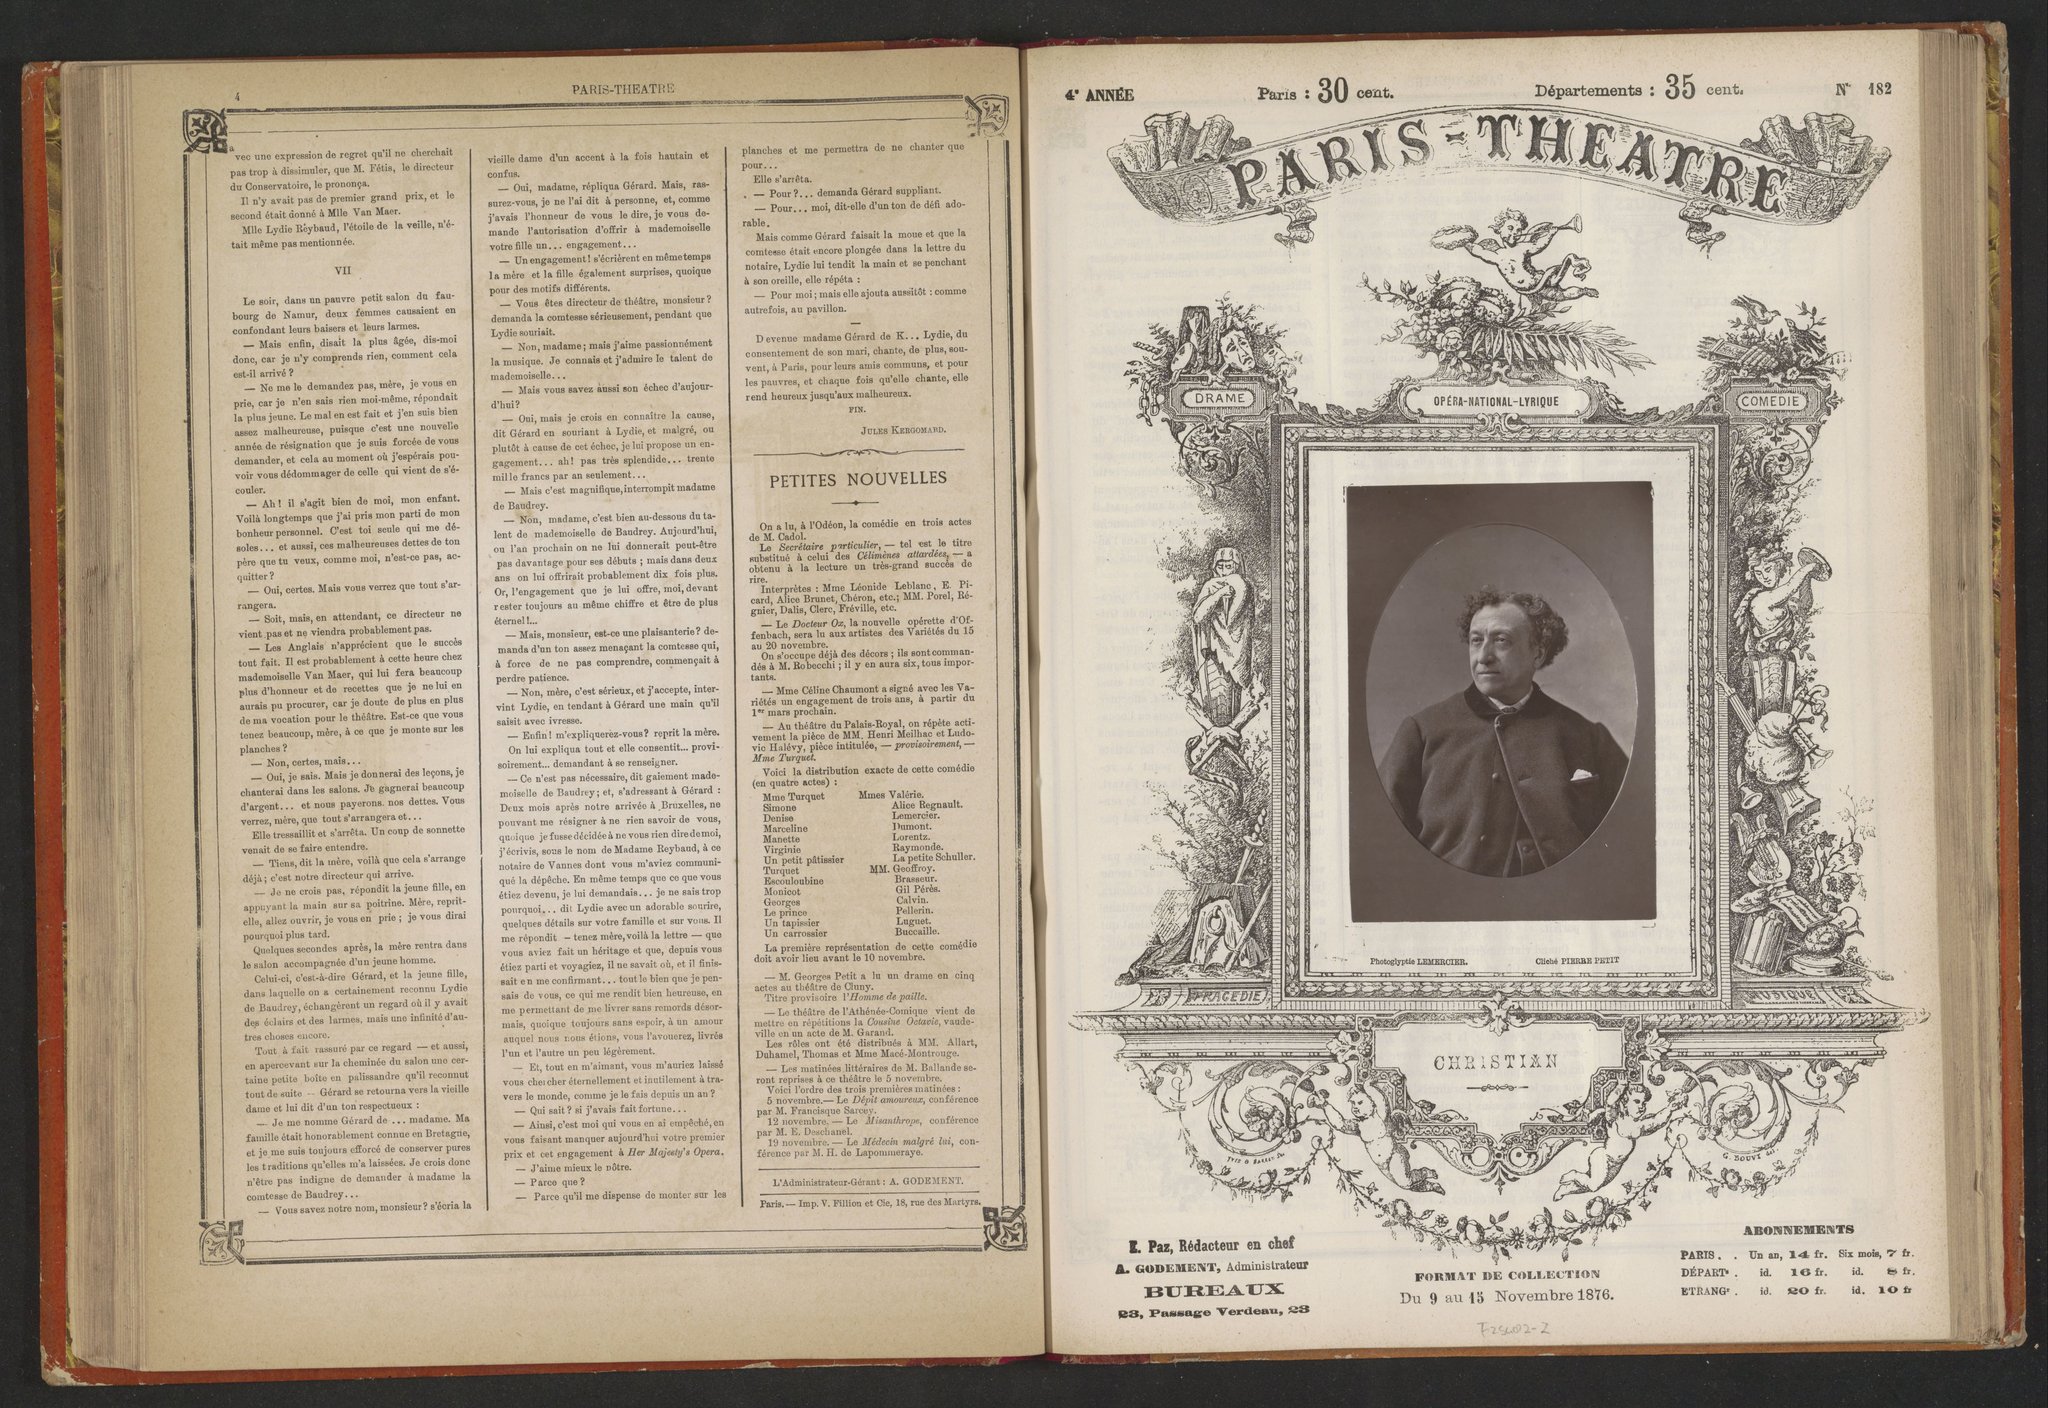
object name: photomechanical print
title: Christian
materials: paper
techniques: woodburytype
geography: paris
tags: portrait of actor, actress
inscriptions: inscription: ‘Du 9 au 15 Novembre 1876.’, number: ‘N' 182’